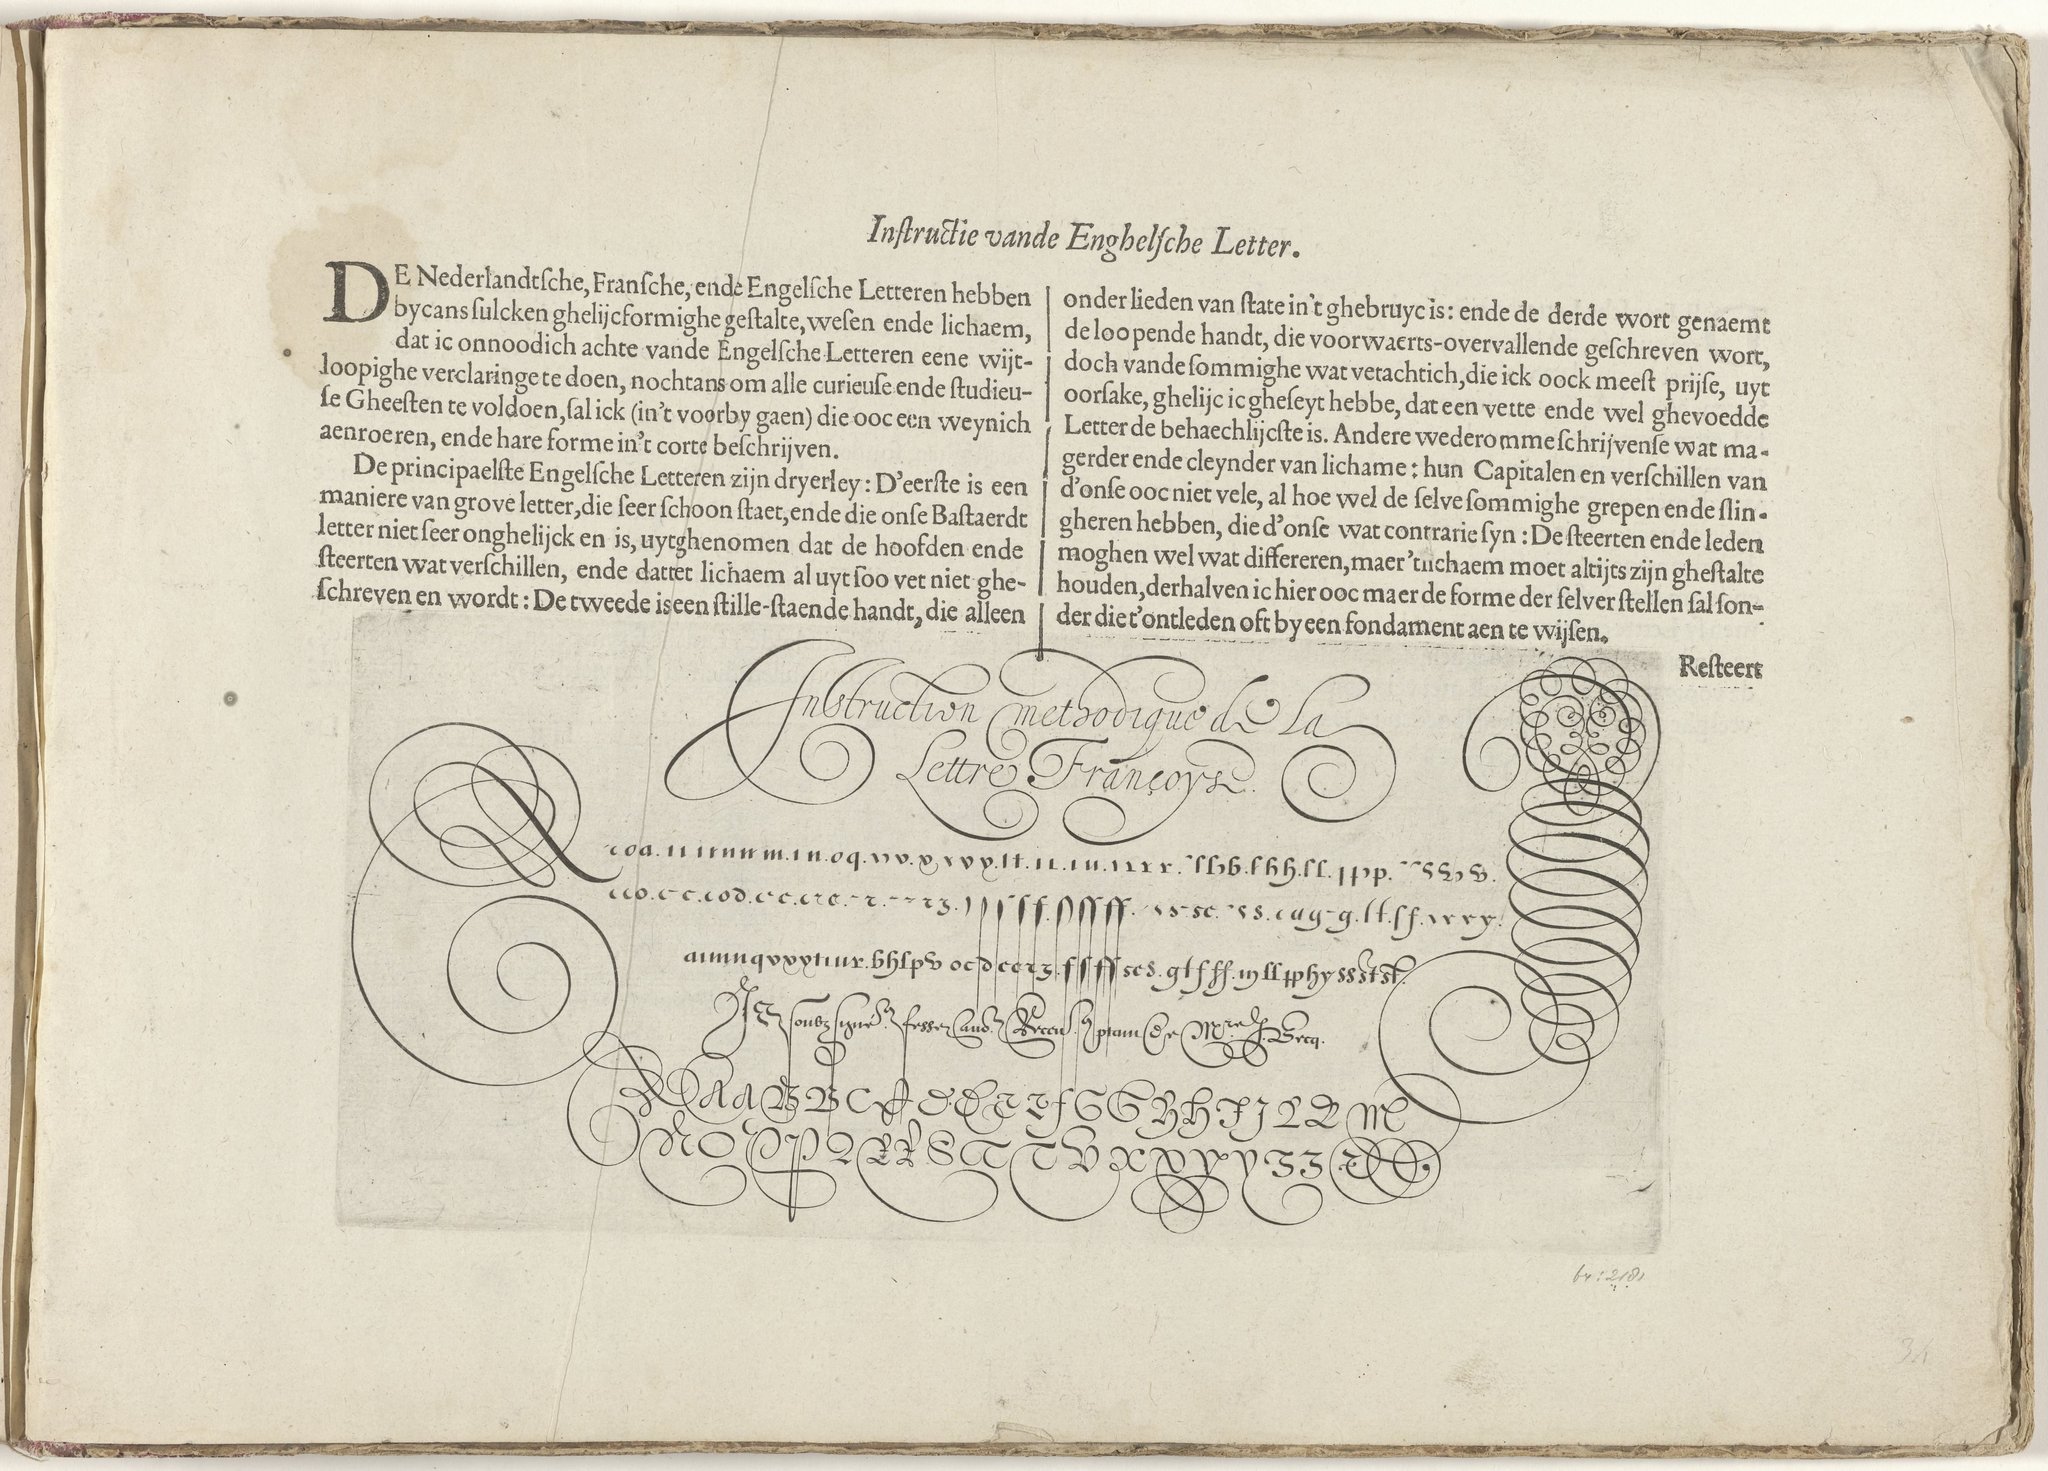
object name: album leaf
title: Spieghel der schrijfkonste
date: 1605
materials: paper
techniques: engraving, letterpress printing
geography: amsterdam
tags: calligraphy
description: Folio H2v met een beschrijving van de Engelse letter. Daaronder echter het schrijfvoorbeeld van de Franse letteren getiteld: Instruction methodique de la Lettre Francoyse. Het blad maakt deel uit van een album.